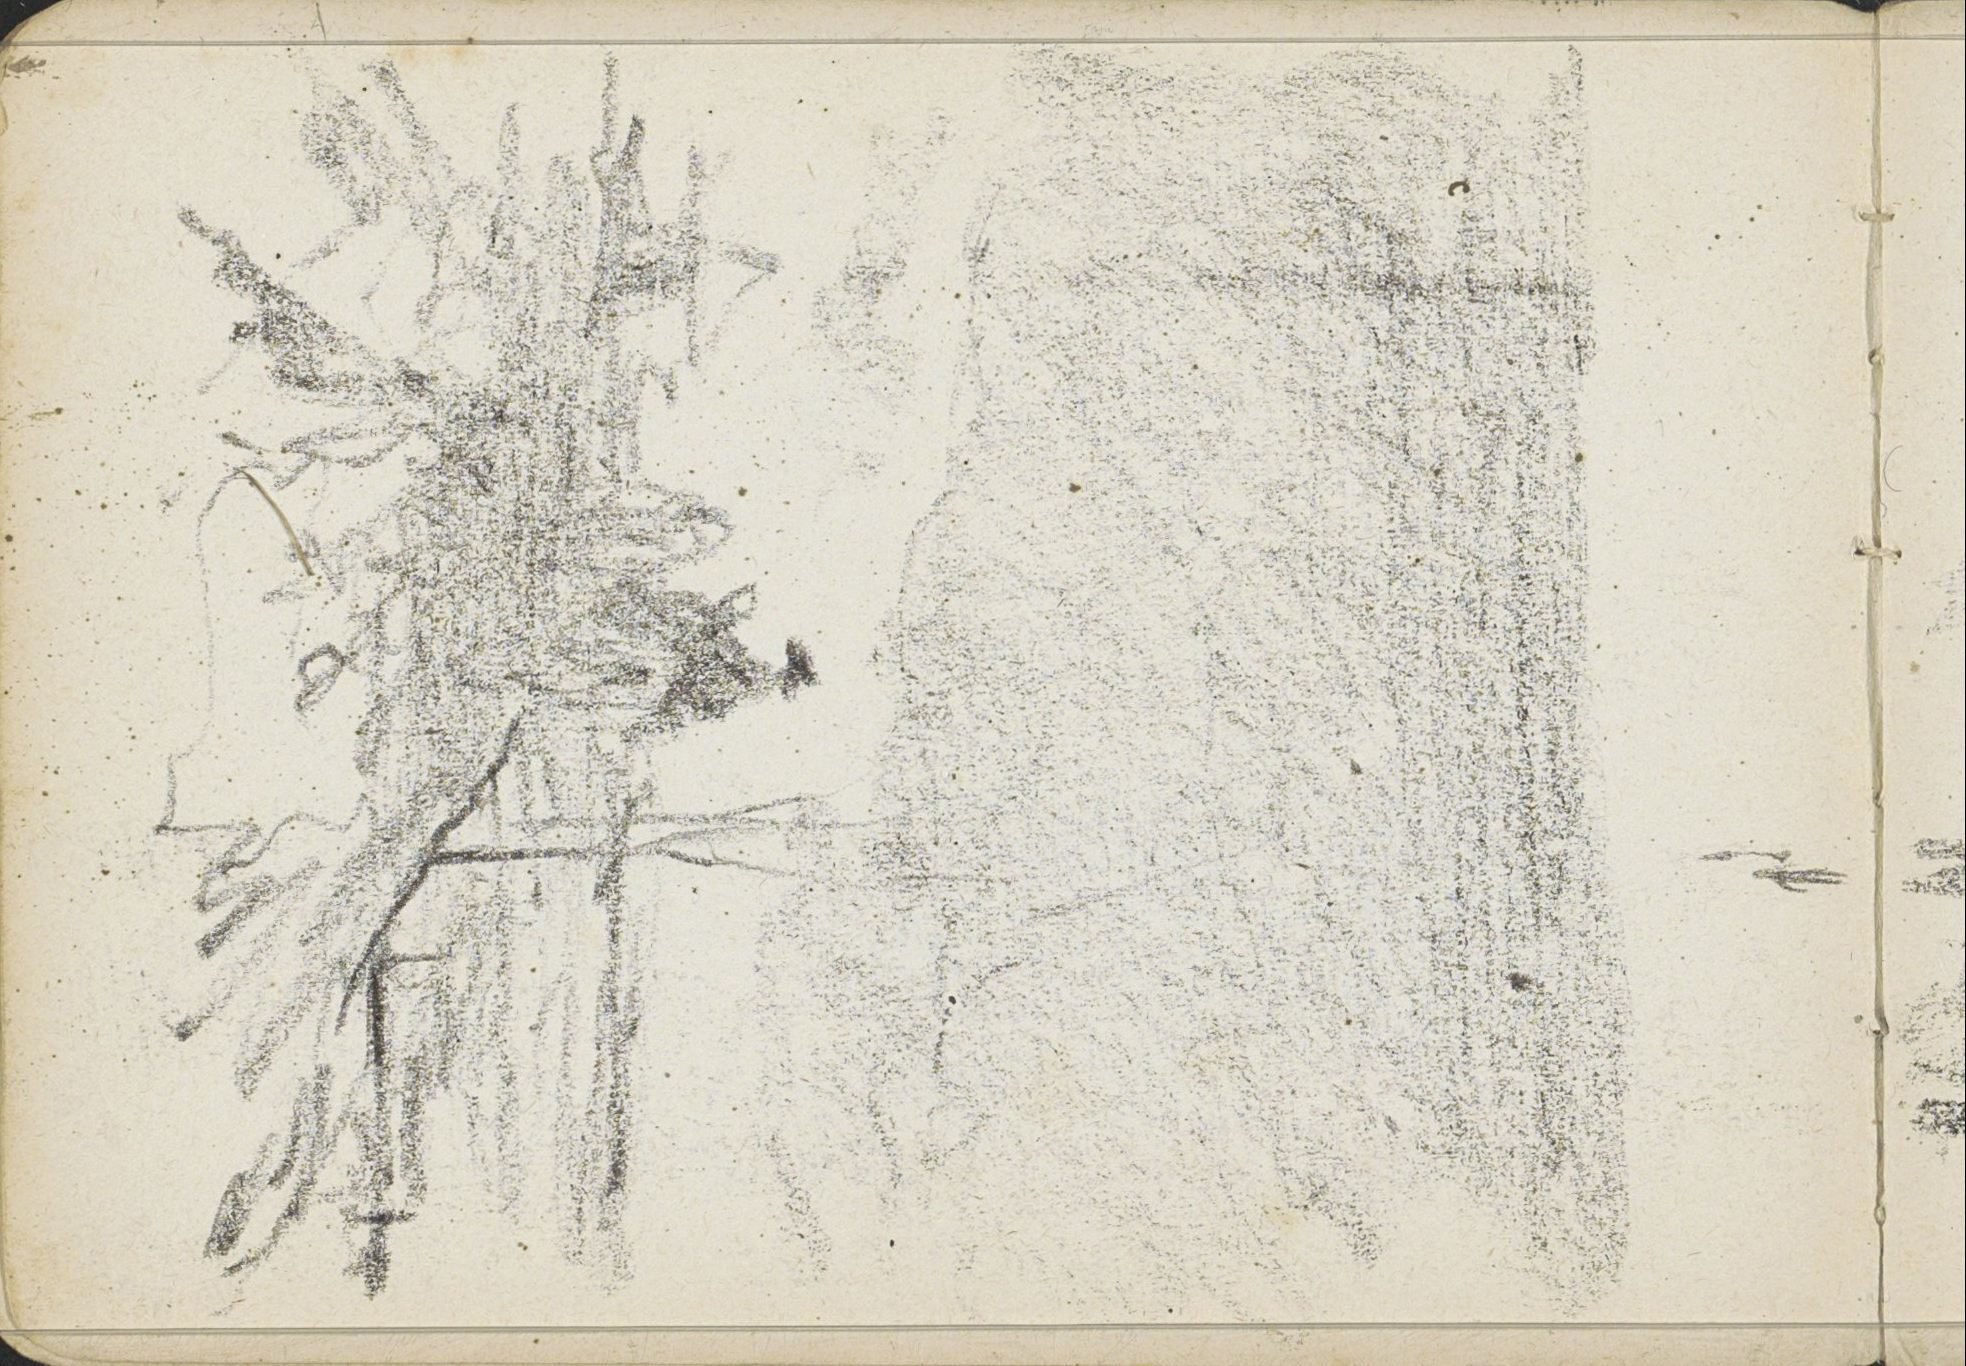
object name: sketchbook leaf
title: Landschap met een ruiter op een pad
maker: willem cornelis rip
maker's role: draughtsman, painter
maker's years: 1856-1922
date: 1866-1922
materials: chalk, paper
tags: riding a horse, ass, or mule; rider, horseman, road, path, landscapes (+ landscape with figures, staffage)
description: Blad 2 verso uit een schetsboek met 42 bladen.